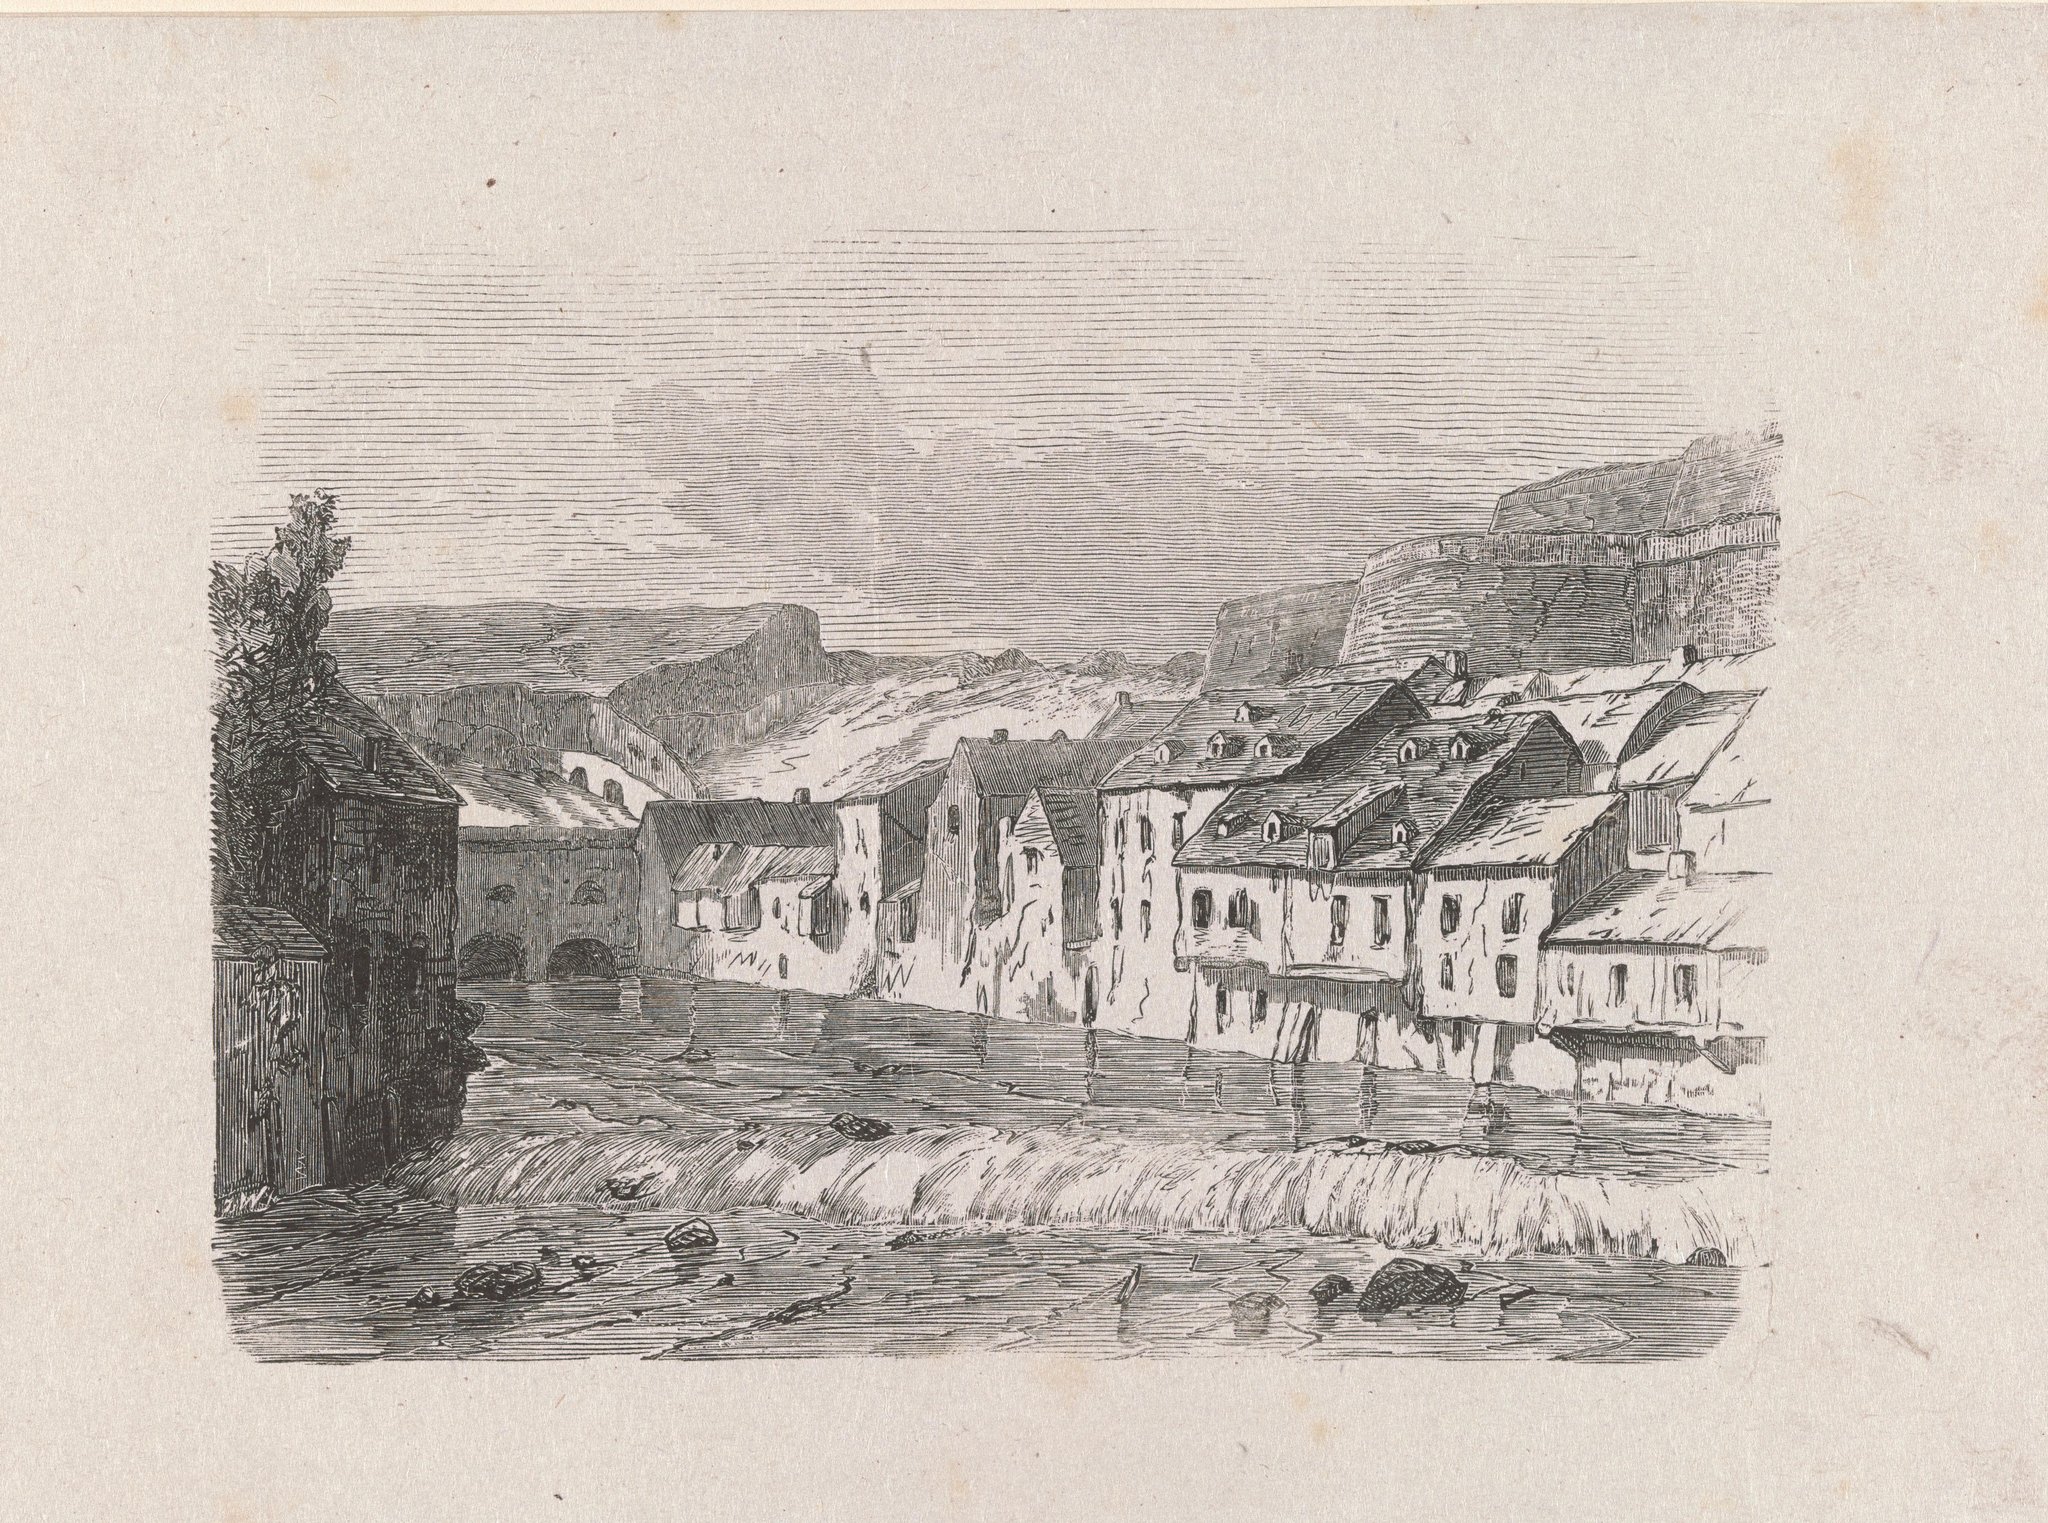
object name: print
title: Rivier stromend door een dorp in de bergen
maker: isaac weissenbruch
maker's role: print maker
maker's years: 1826-1912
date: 1836-1912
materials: paper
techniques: engraving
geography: netherlands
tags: river, village, mountains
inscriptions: collector's mark: Lugt 2228